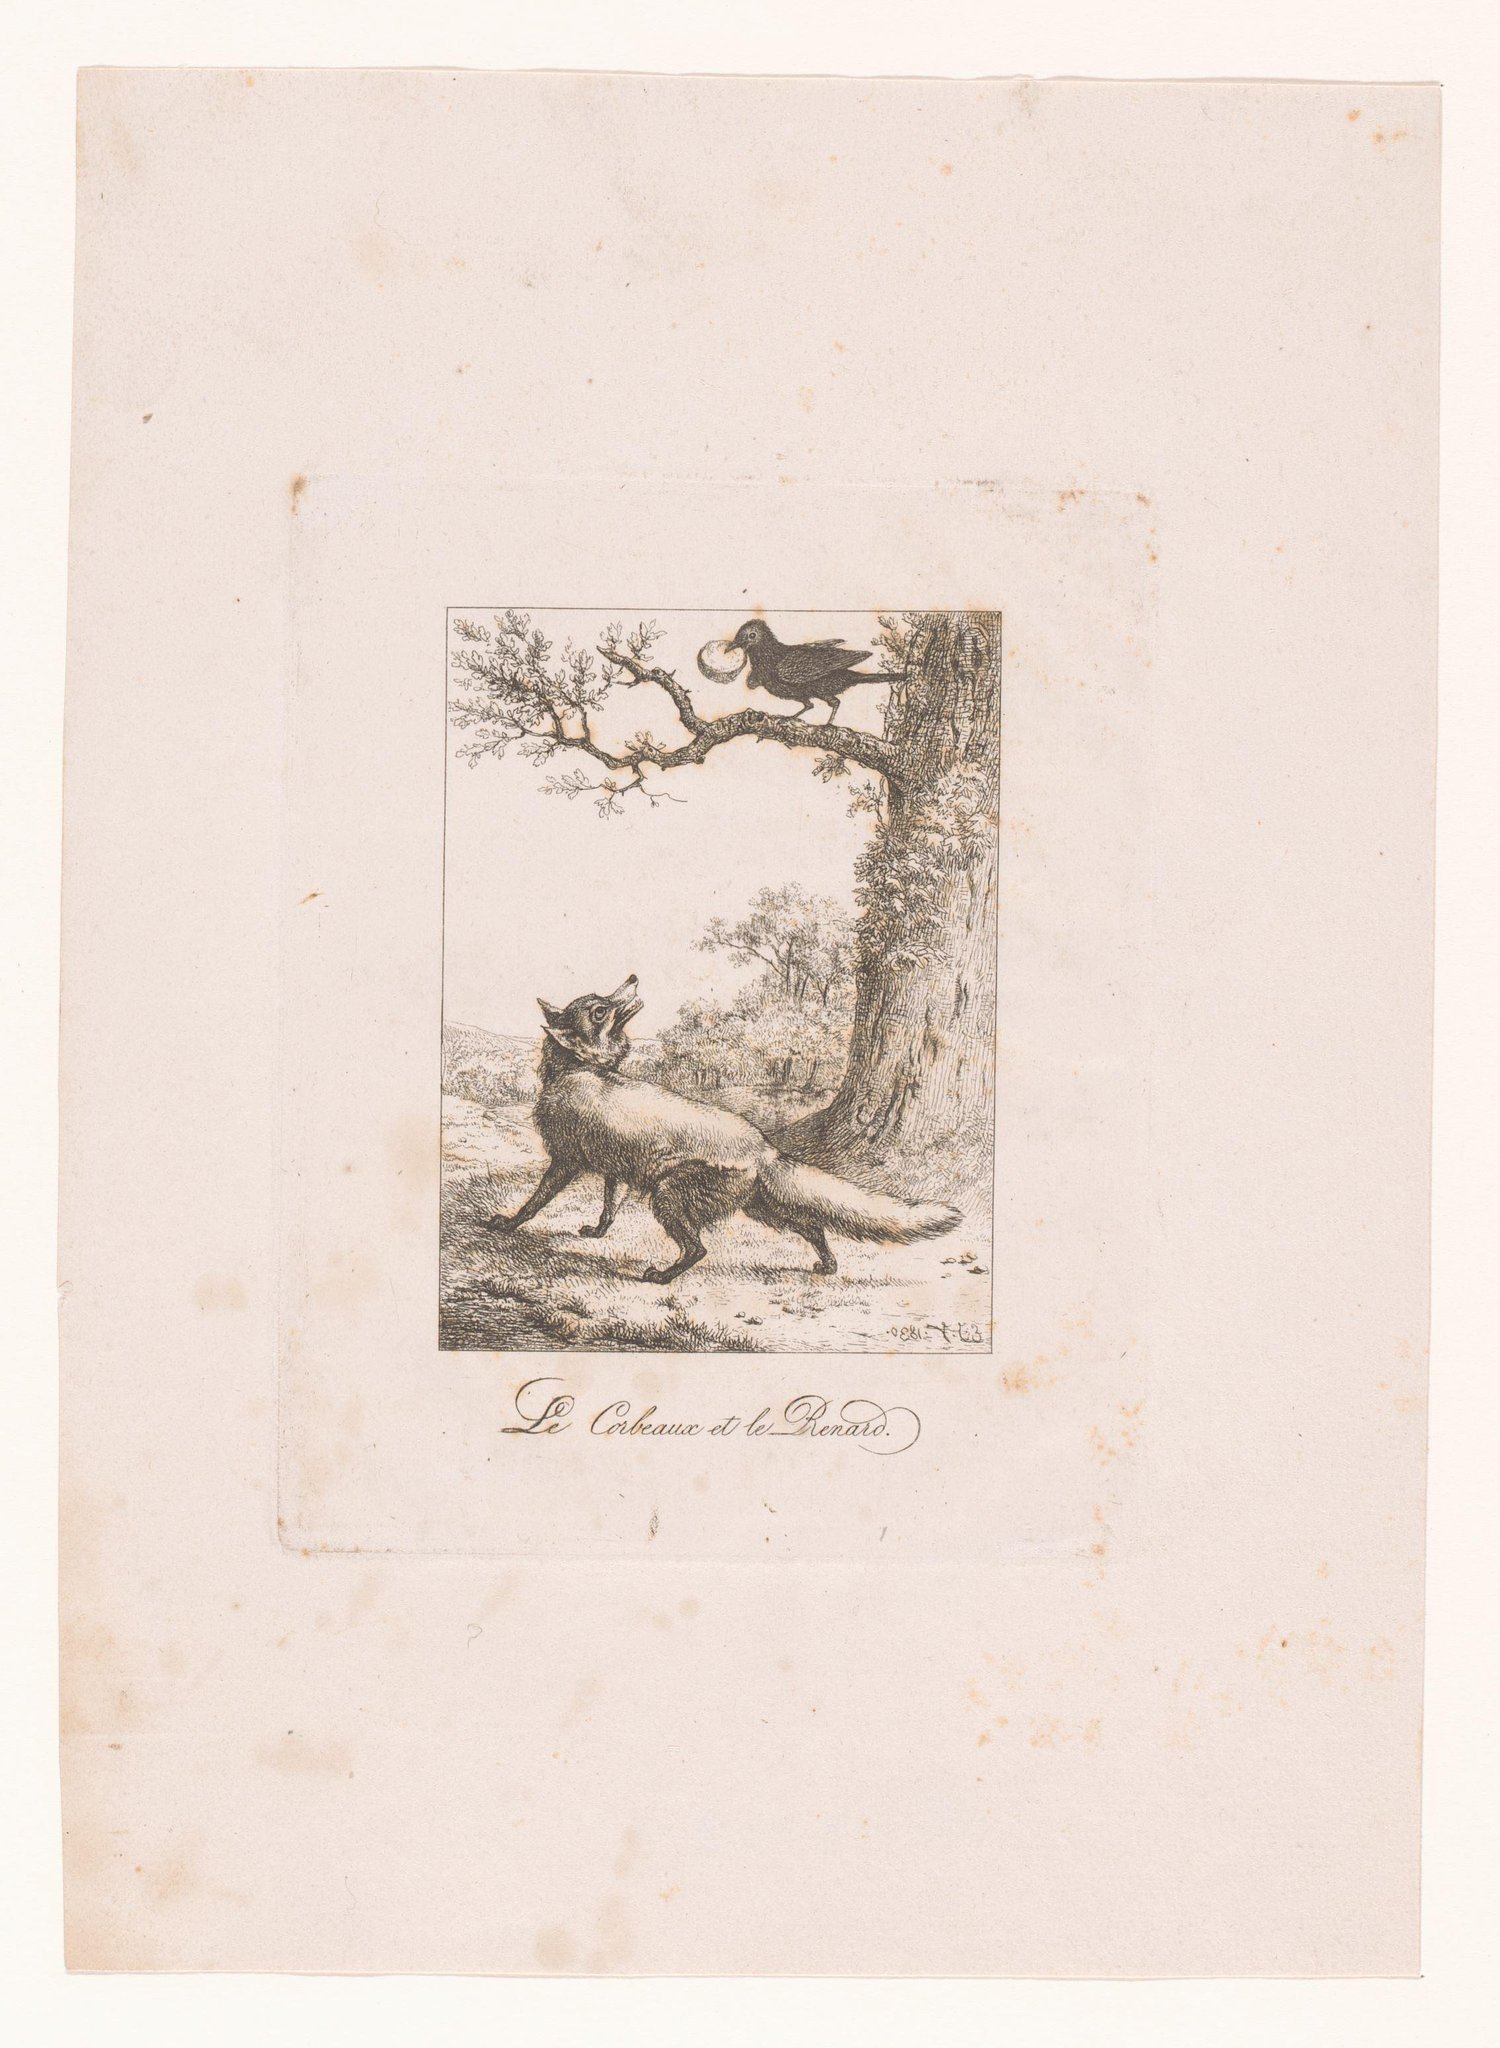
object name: print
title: Fabel van de raaf en de vos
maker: eugène verboeckhoven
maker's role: draughtsman, painter, print maker, printer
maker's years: 1798-1881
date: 1830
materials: paper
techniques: etching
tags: fable of the fox and the raven, song-birds: raven, beasts of prey, predatory animals: fox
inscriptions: date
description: Prent maakt deel uit van een serie van acht prenten met scènes uit de fabels van Jean de La Fontaine.